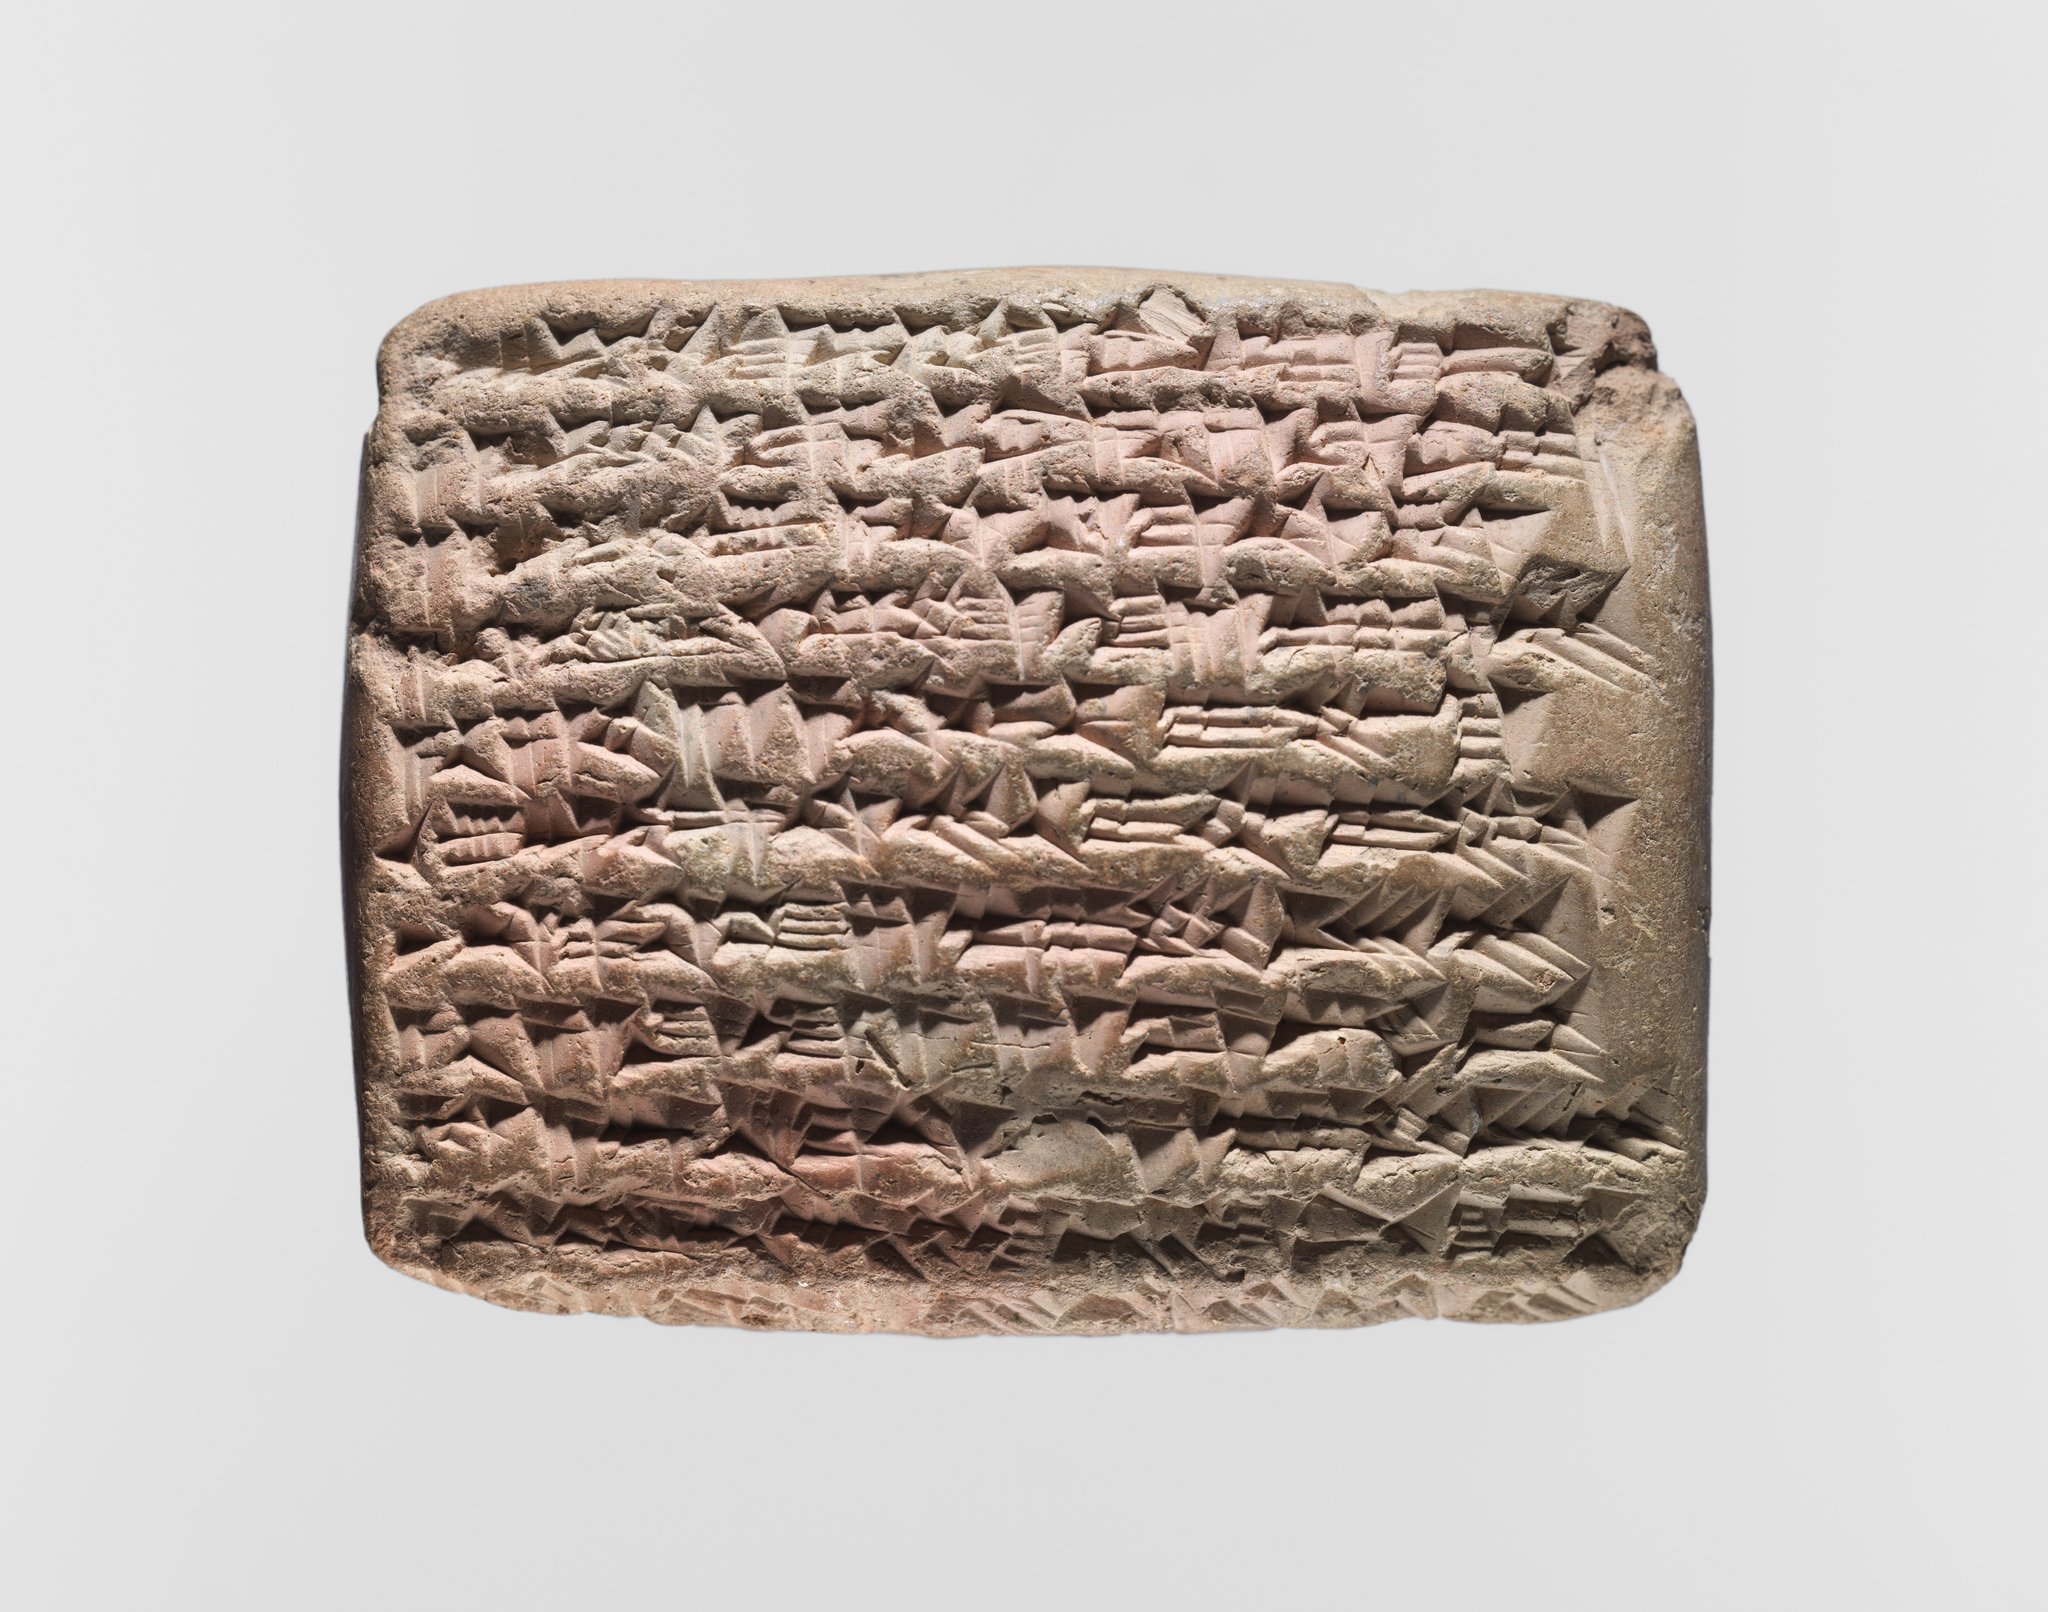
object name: cuneiform tablet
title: Cuneiform tablet: proxy contract for the purchase of a slave, Egibi archive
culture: babylonian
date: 554 BCE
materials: clay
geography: mesopotamia